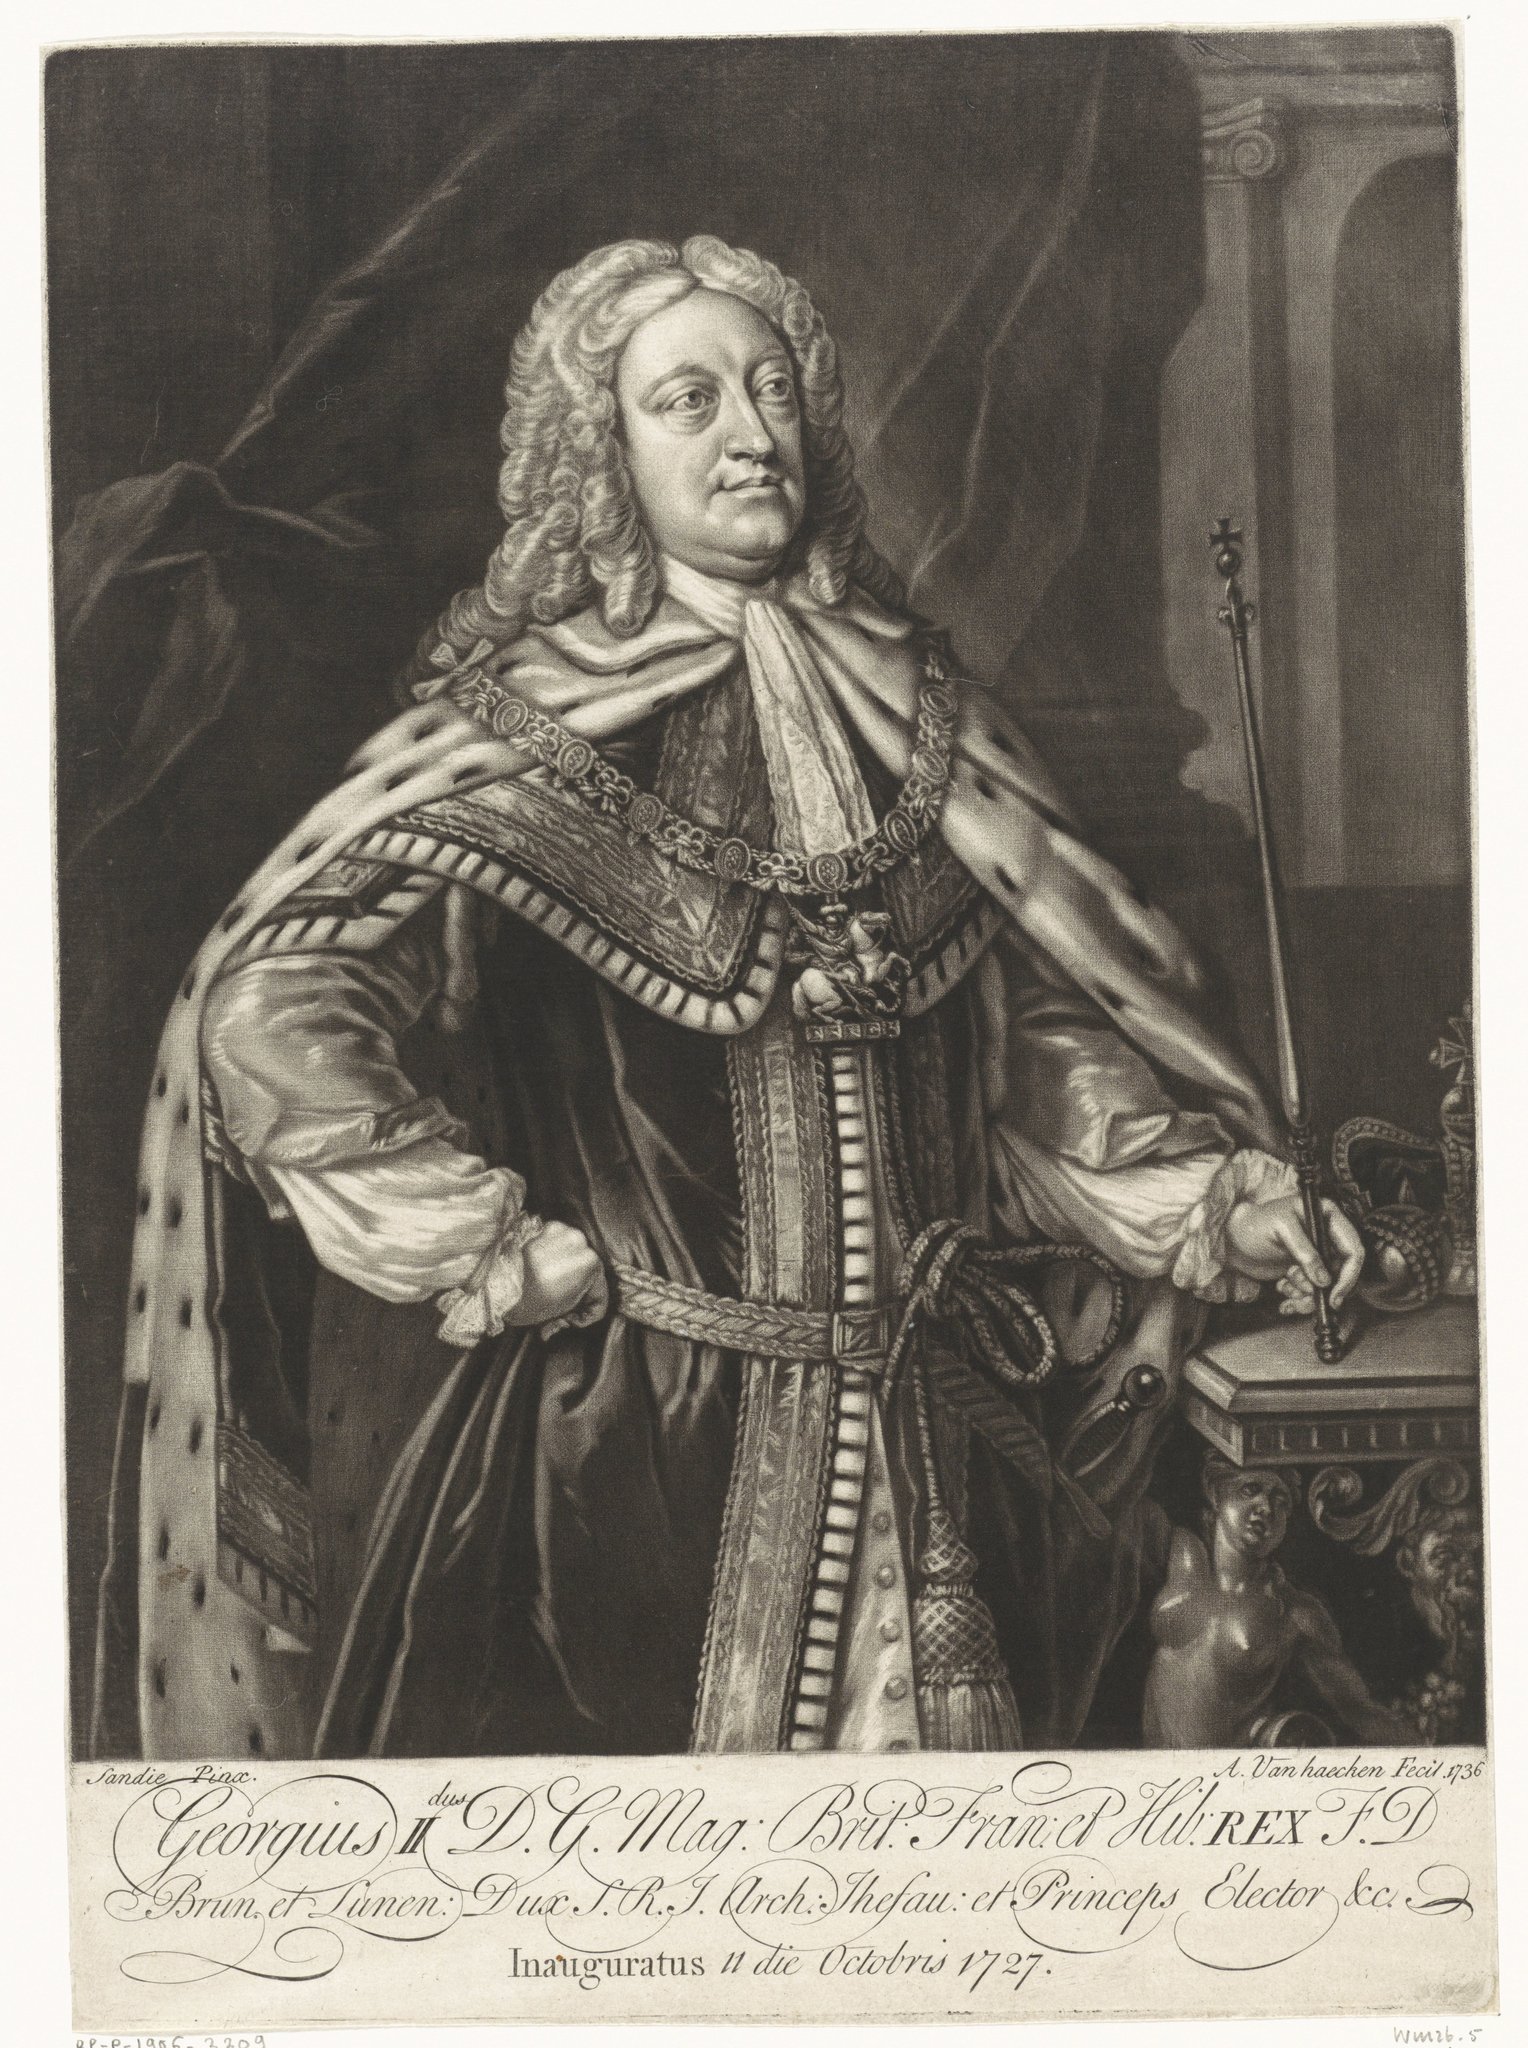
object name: print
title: Portret van George II Augustus van Groot-Brittannië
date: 1736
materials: paper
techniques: engraving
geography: london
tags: london, george ii augustus (koning van groot-brittannië), orb (symbol of sovereignty; sphere with cross on top), ruler, sovereign, insignia and symbols of sovereignty (crown, diadem, sceptre, orb, seal, standard, cloak, pectoral)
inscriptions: collector's mark: Lugt 2228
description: George II Augustus van Hannover, koning van Groot-Brittannië met in de hand een scepter en om de hals een keten met het ordeteken van de orde van de Kousenband. Hij draagt de kroningsmantel. Op de tafel naast hem de rijksappel en de koningskroon.